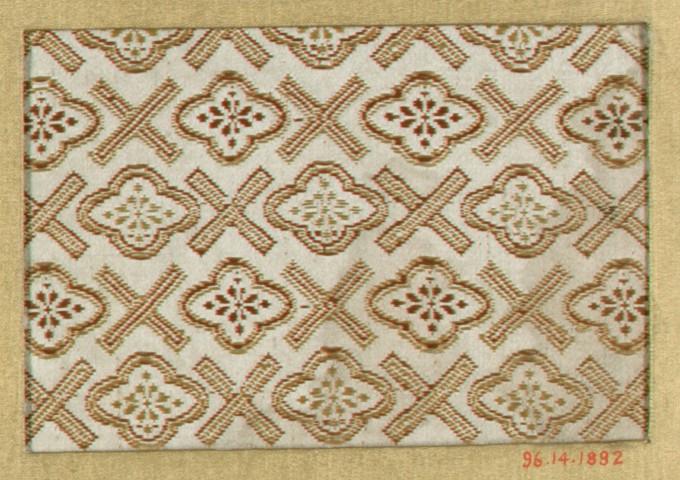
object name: piece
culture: japanese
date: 1701-1900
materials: silk